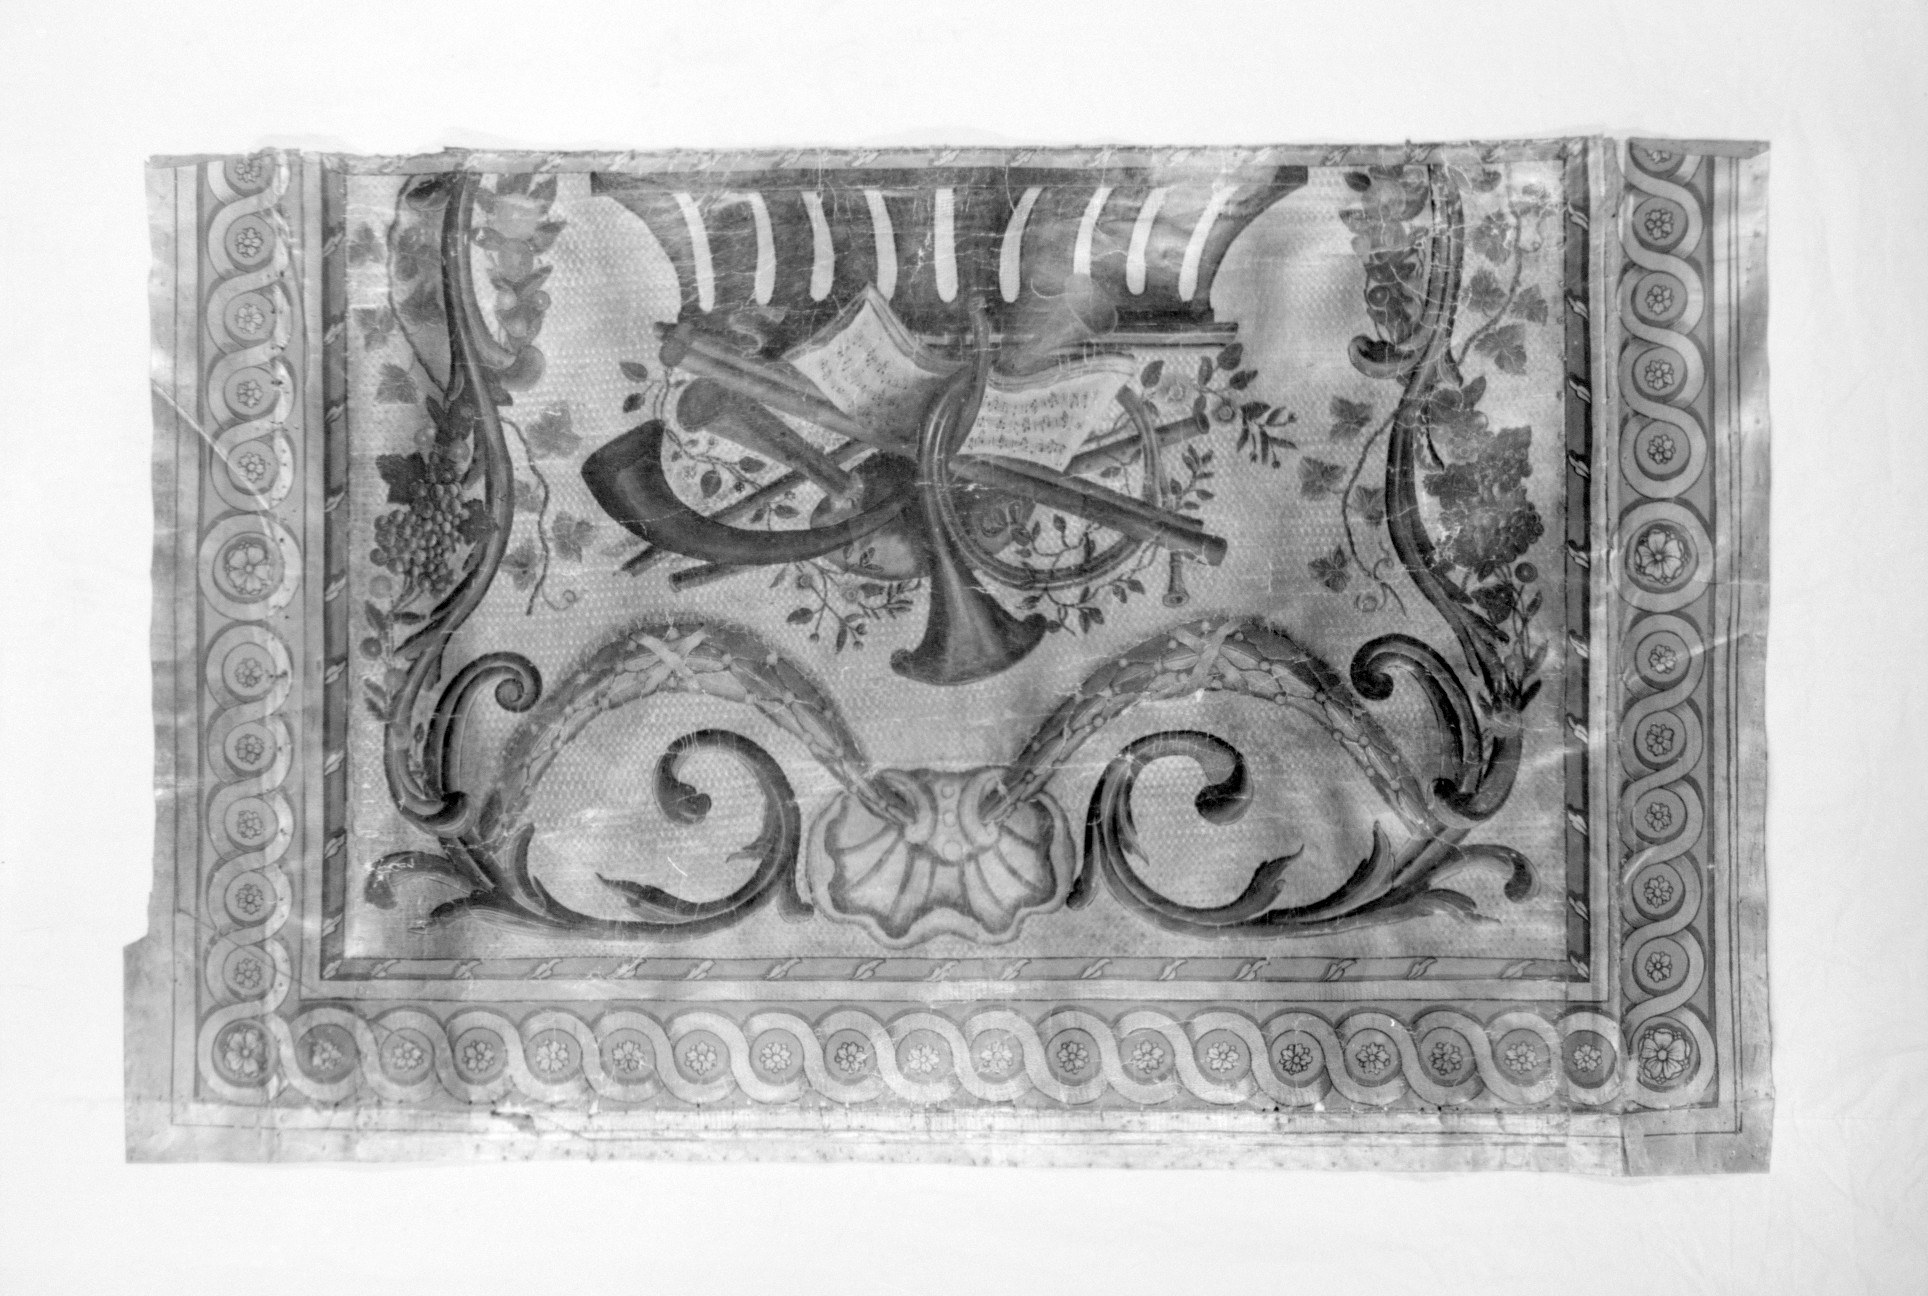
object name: wall hanging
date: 1601-1800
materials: leather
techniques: gilding, painting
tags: musical instruments